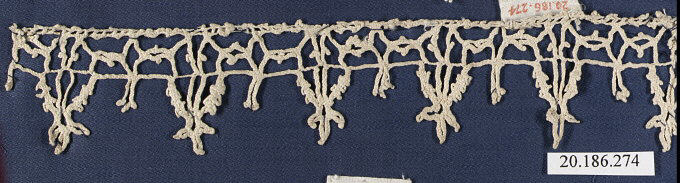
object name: edging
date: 1501-1600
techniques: lace